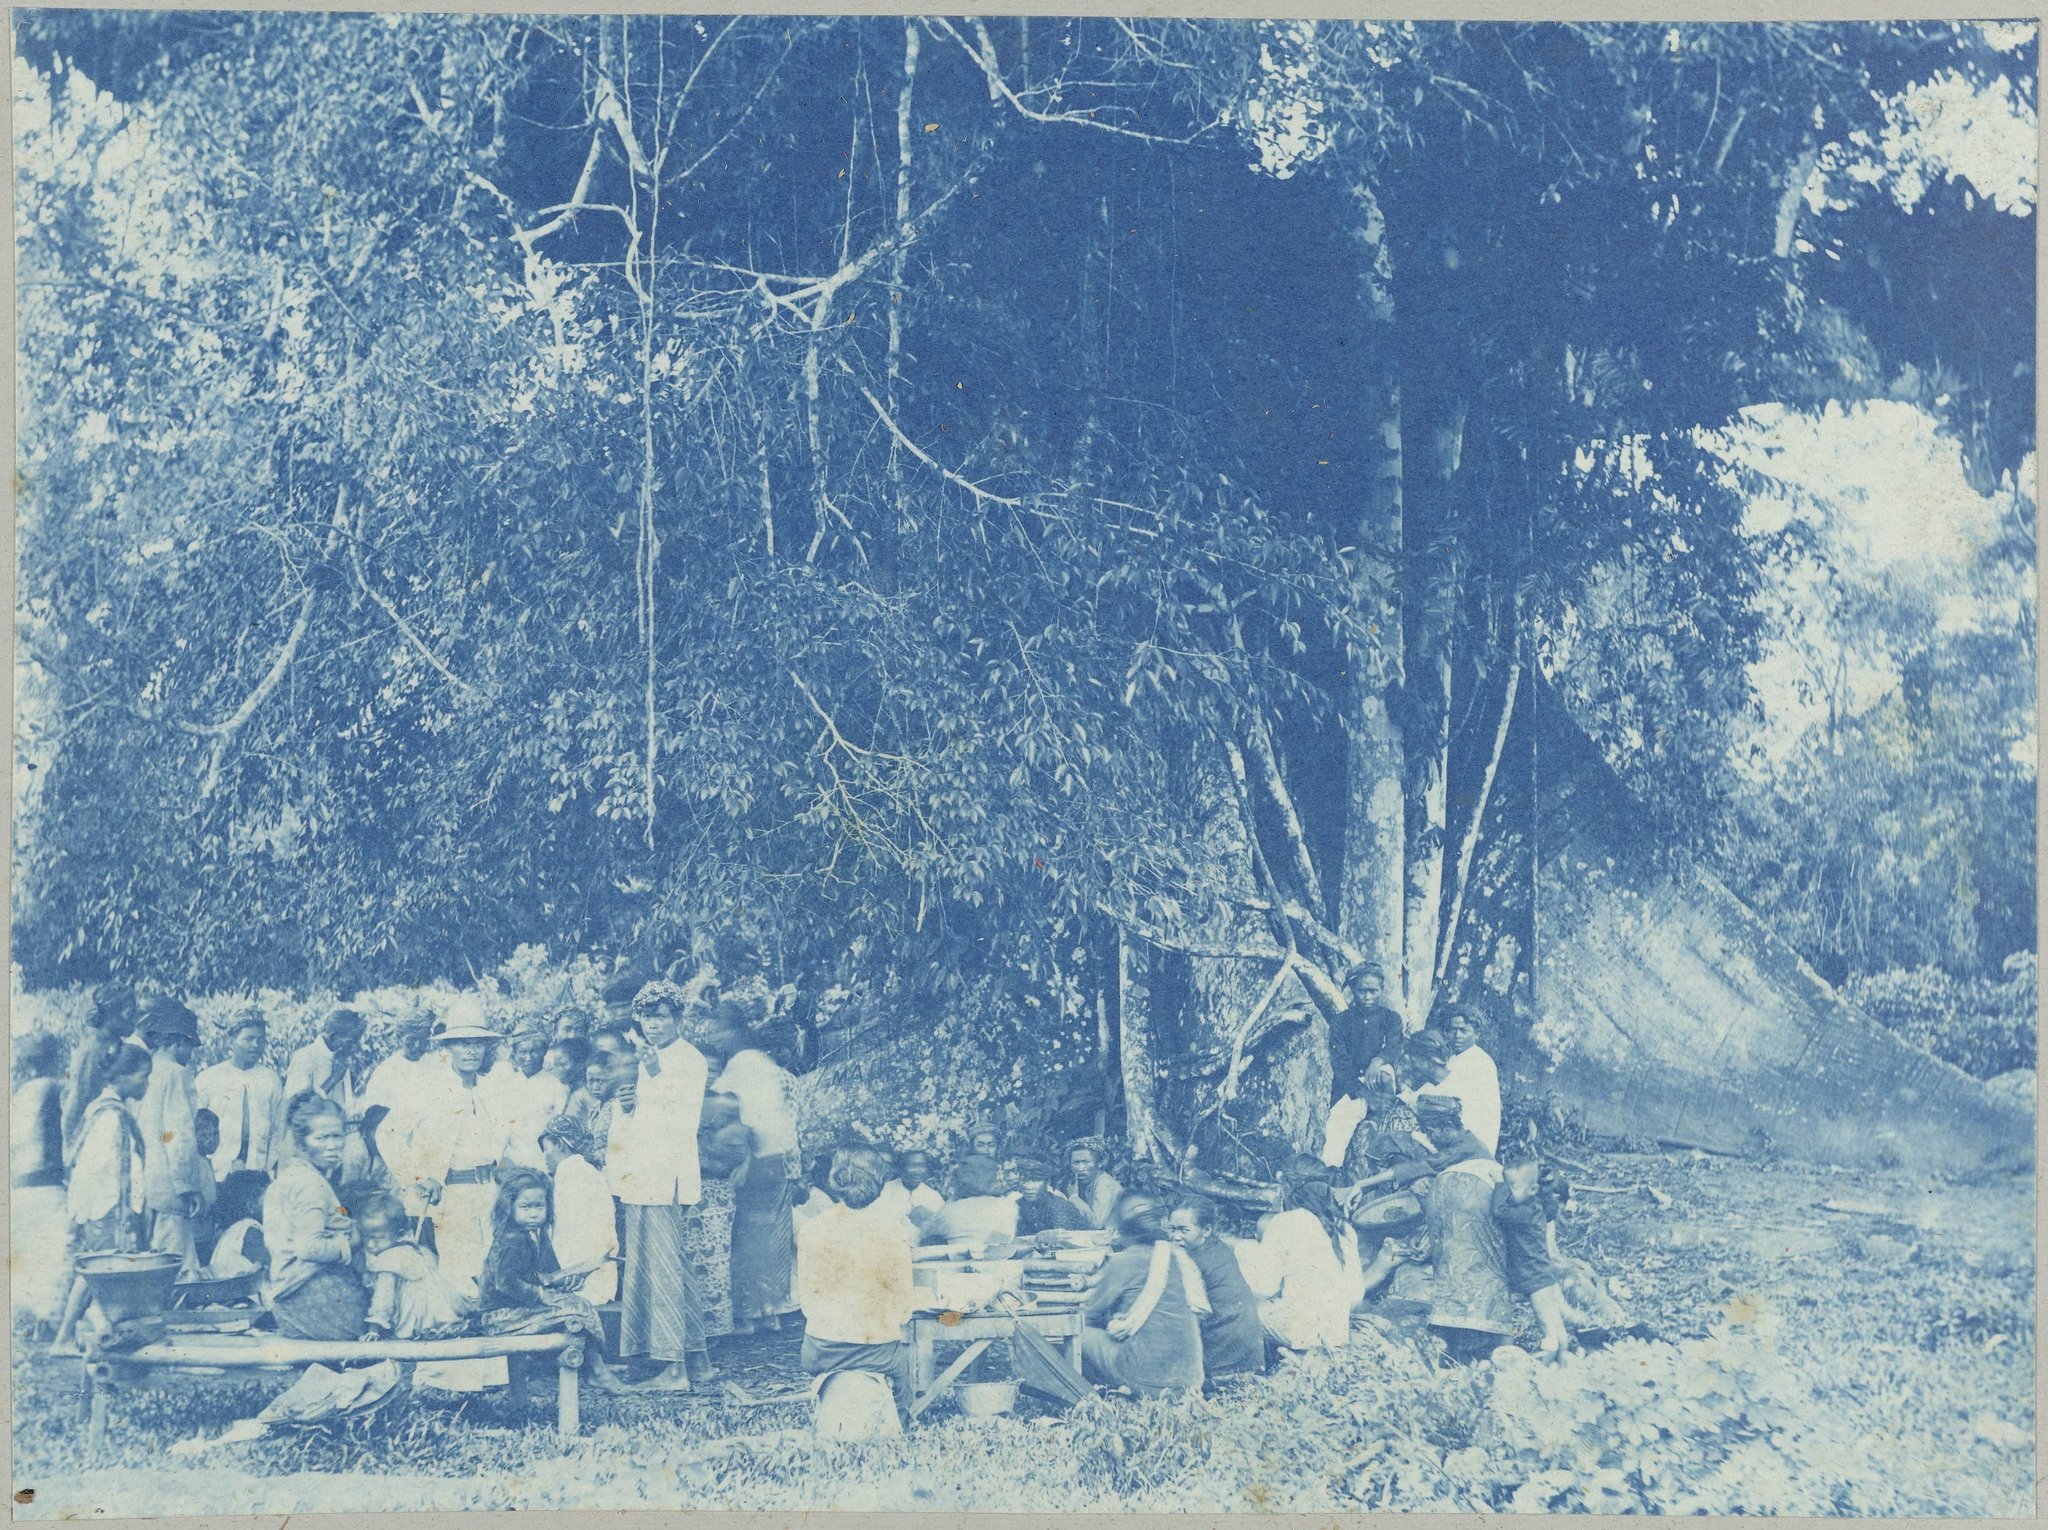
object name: photograph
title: Javanenmarkt onder kankantree op "Ma retraite"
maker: hendrik doijer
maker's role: engineer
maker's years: 1863-1925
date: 1903-1910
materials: photographic support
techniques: cyanotype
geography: suriname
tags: suriname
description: Kleine markt van Javanen in de openlucht onder een grote boom (kankantrie of wilde kapokboom) op het terrein van de plantage Ma Retraite. Onderdeel van het fotoalbum Souvenir de Voyage (deel 1), over het leven van de familie Doijer in en rond de plantage Ma Retraite in Suriname in de jaren 1903-1910.